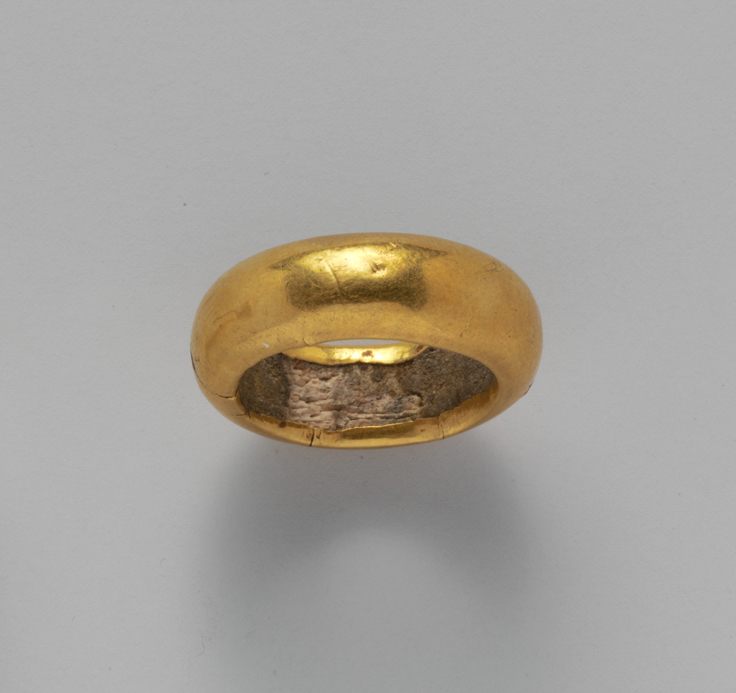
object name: ring with ivory core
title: Gold and ivory ring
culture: etruscan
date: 800-601 BCE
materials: gold, ivory